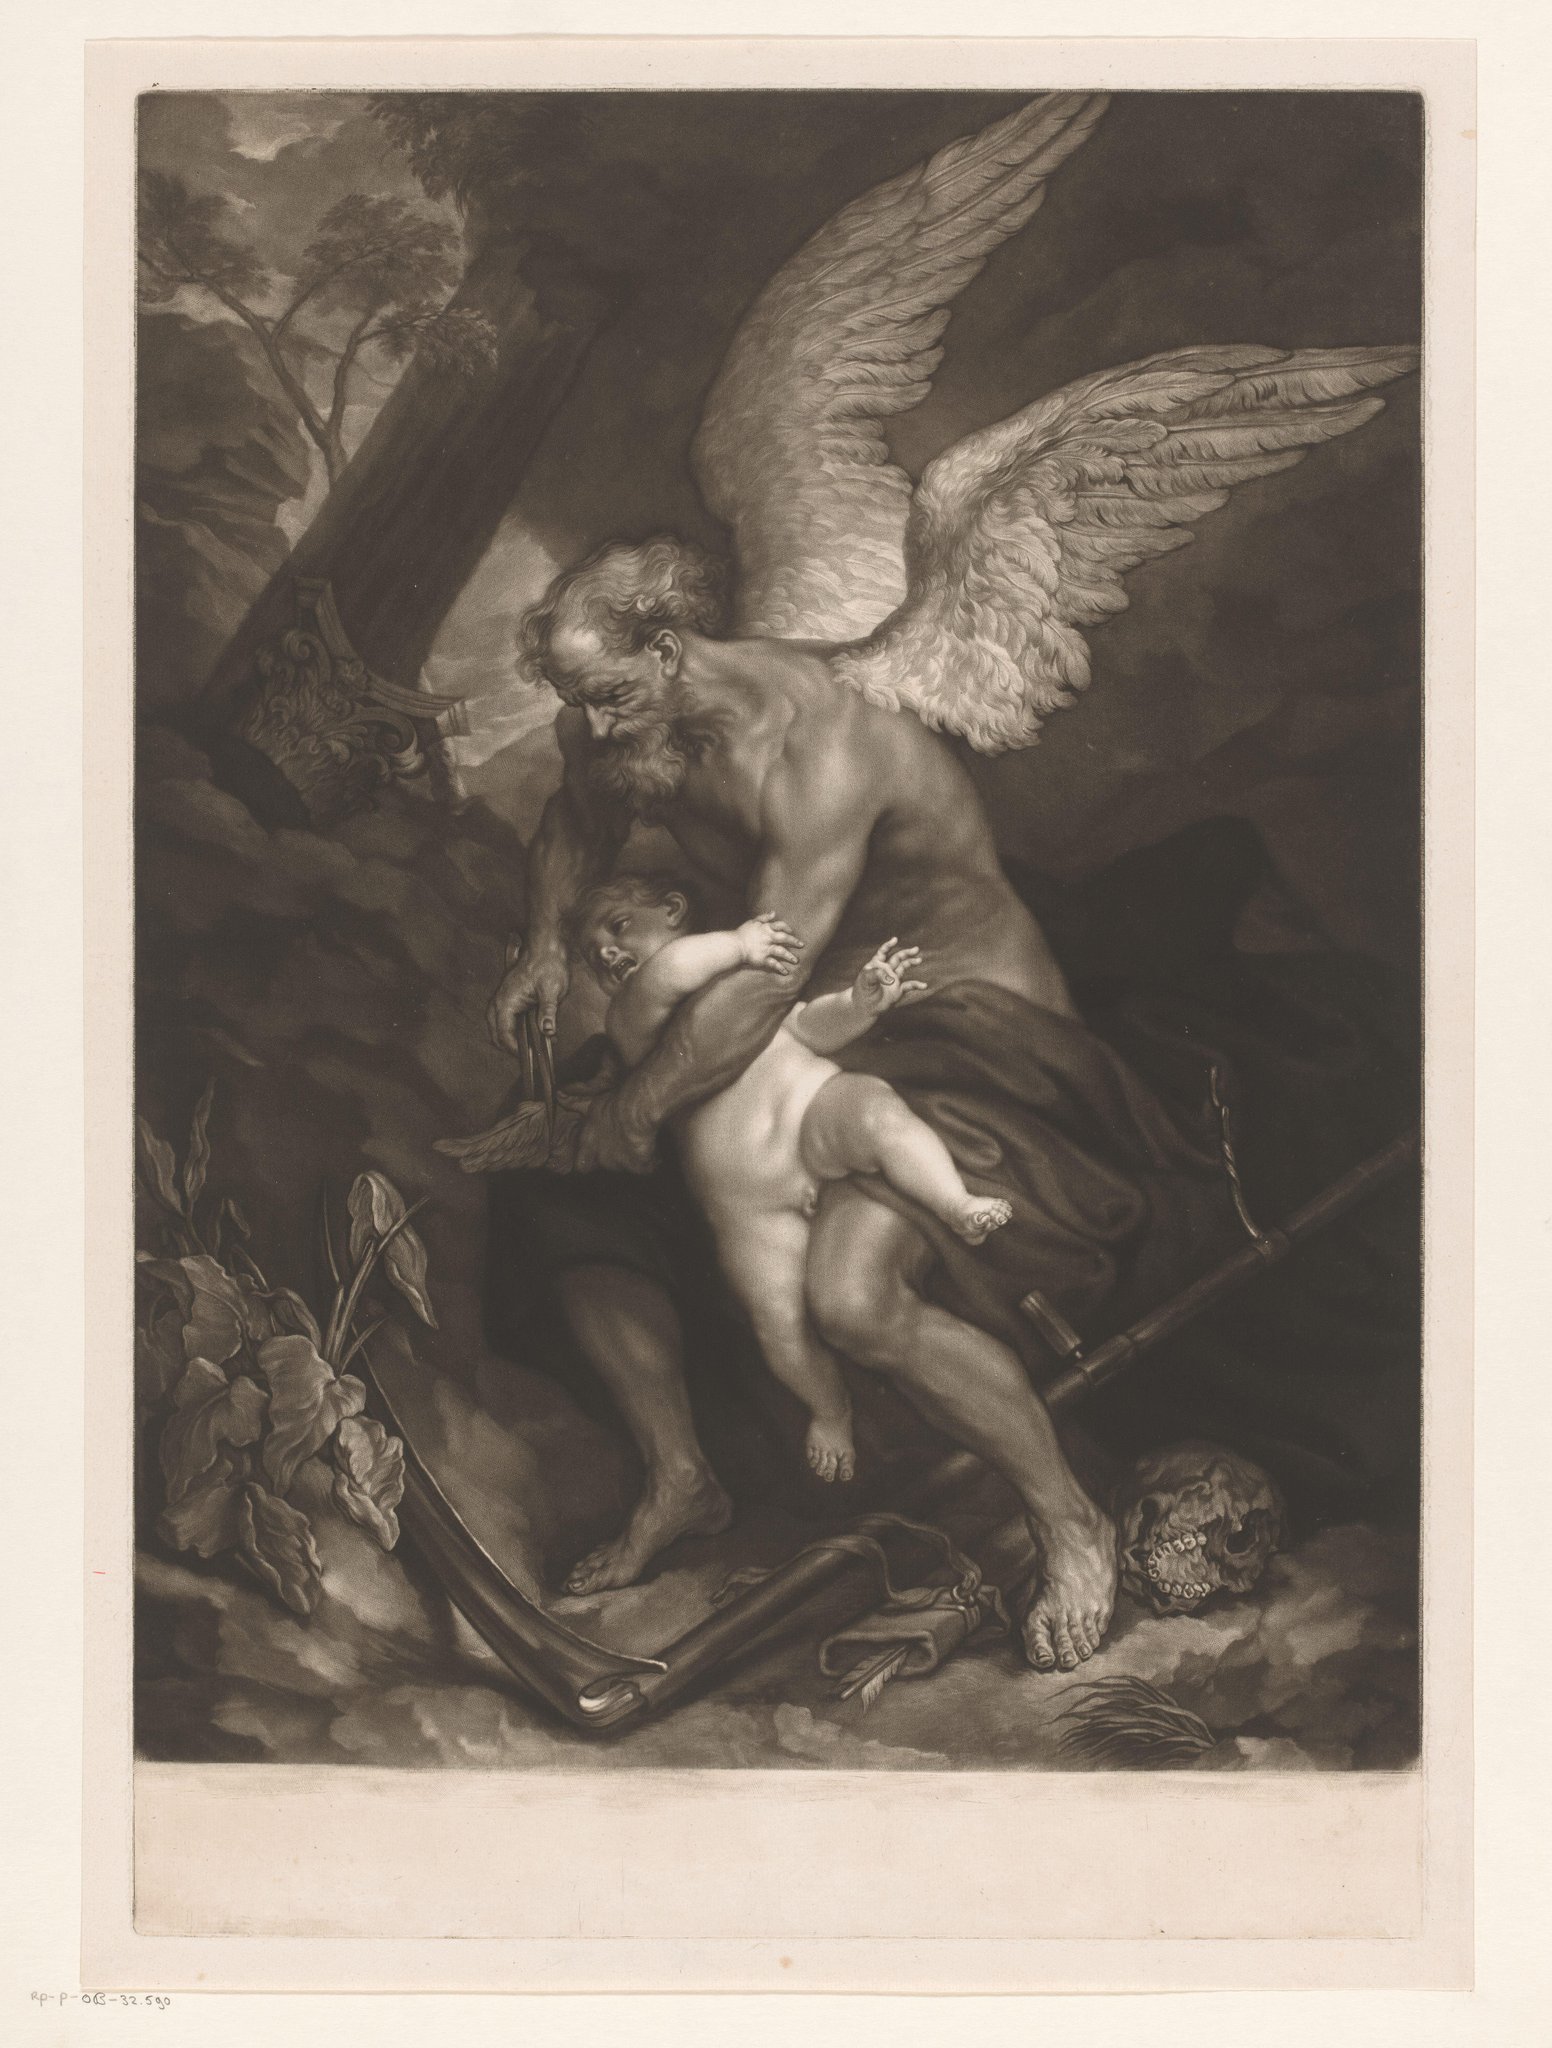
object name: print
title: Tijd knipt de vleugels van Cupido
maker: james mcardell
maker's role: print maker, publisher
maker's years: 1728-1765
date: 1745-1765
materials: paper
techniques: mezzotint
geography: london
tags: punishment of cupid, father time, man with wings and scythe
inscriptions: collector's mark: Lugt 240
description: Christopher Lennox-Boyd suggereert dat de prent beschreven onder Goodwin 209 bestaat uit drie verschillende platen, zie de beschrijving bij R,2.59 in het British Museum.